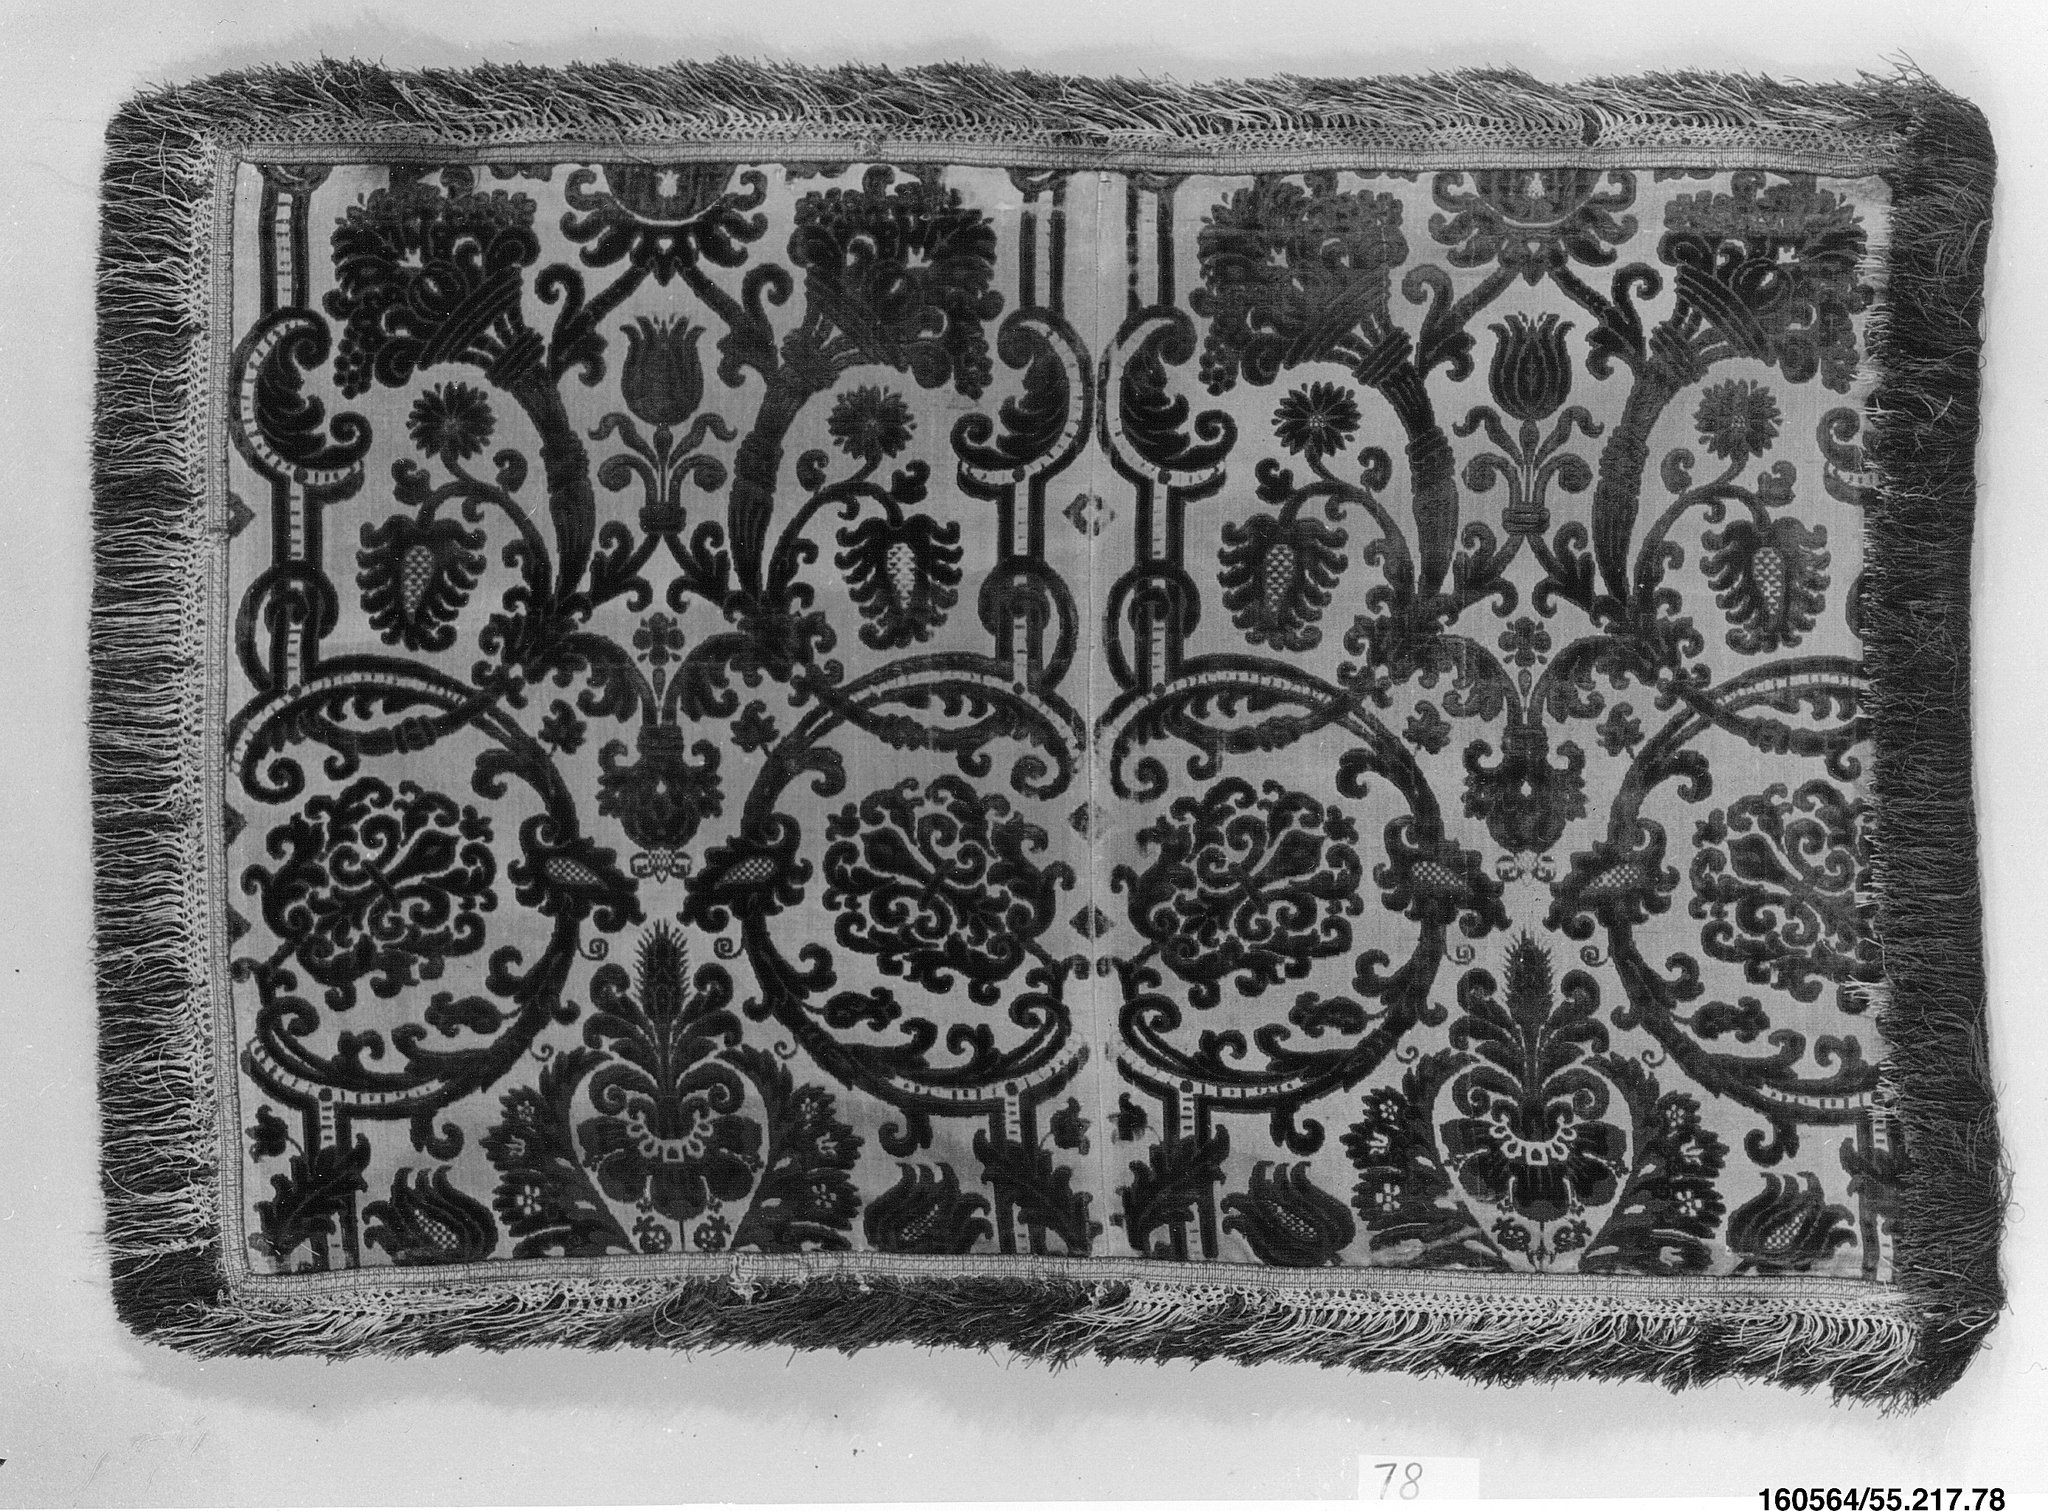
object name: piece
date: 1601-1700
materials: metal thread, silk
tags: flowers,leaves